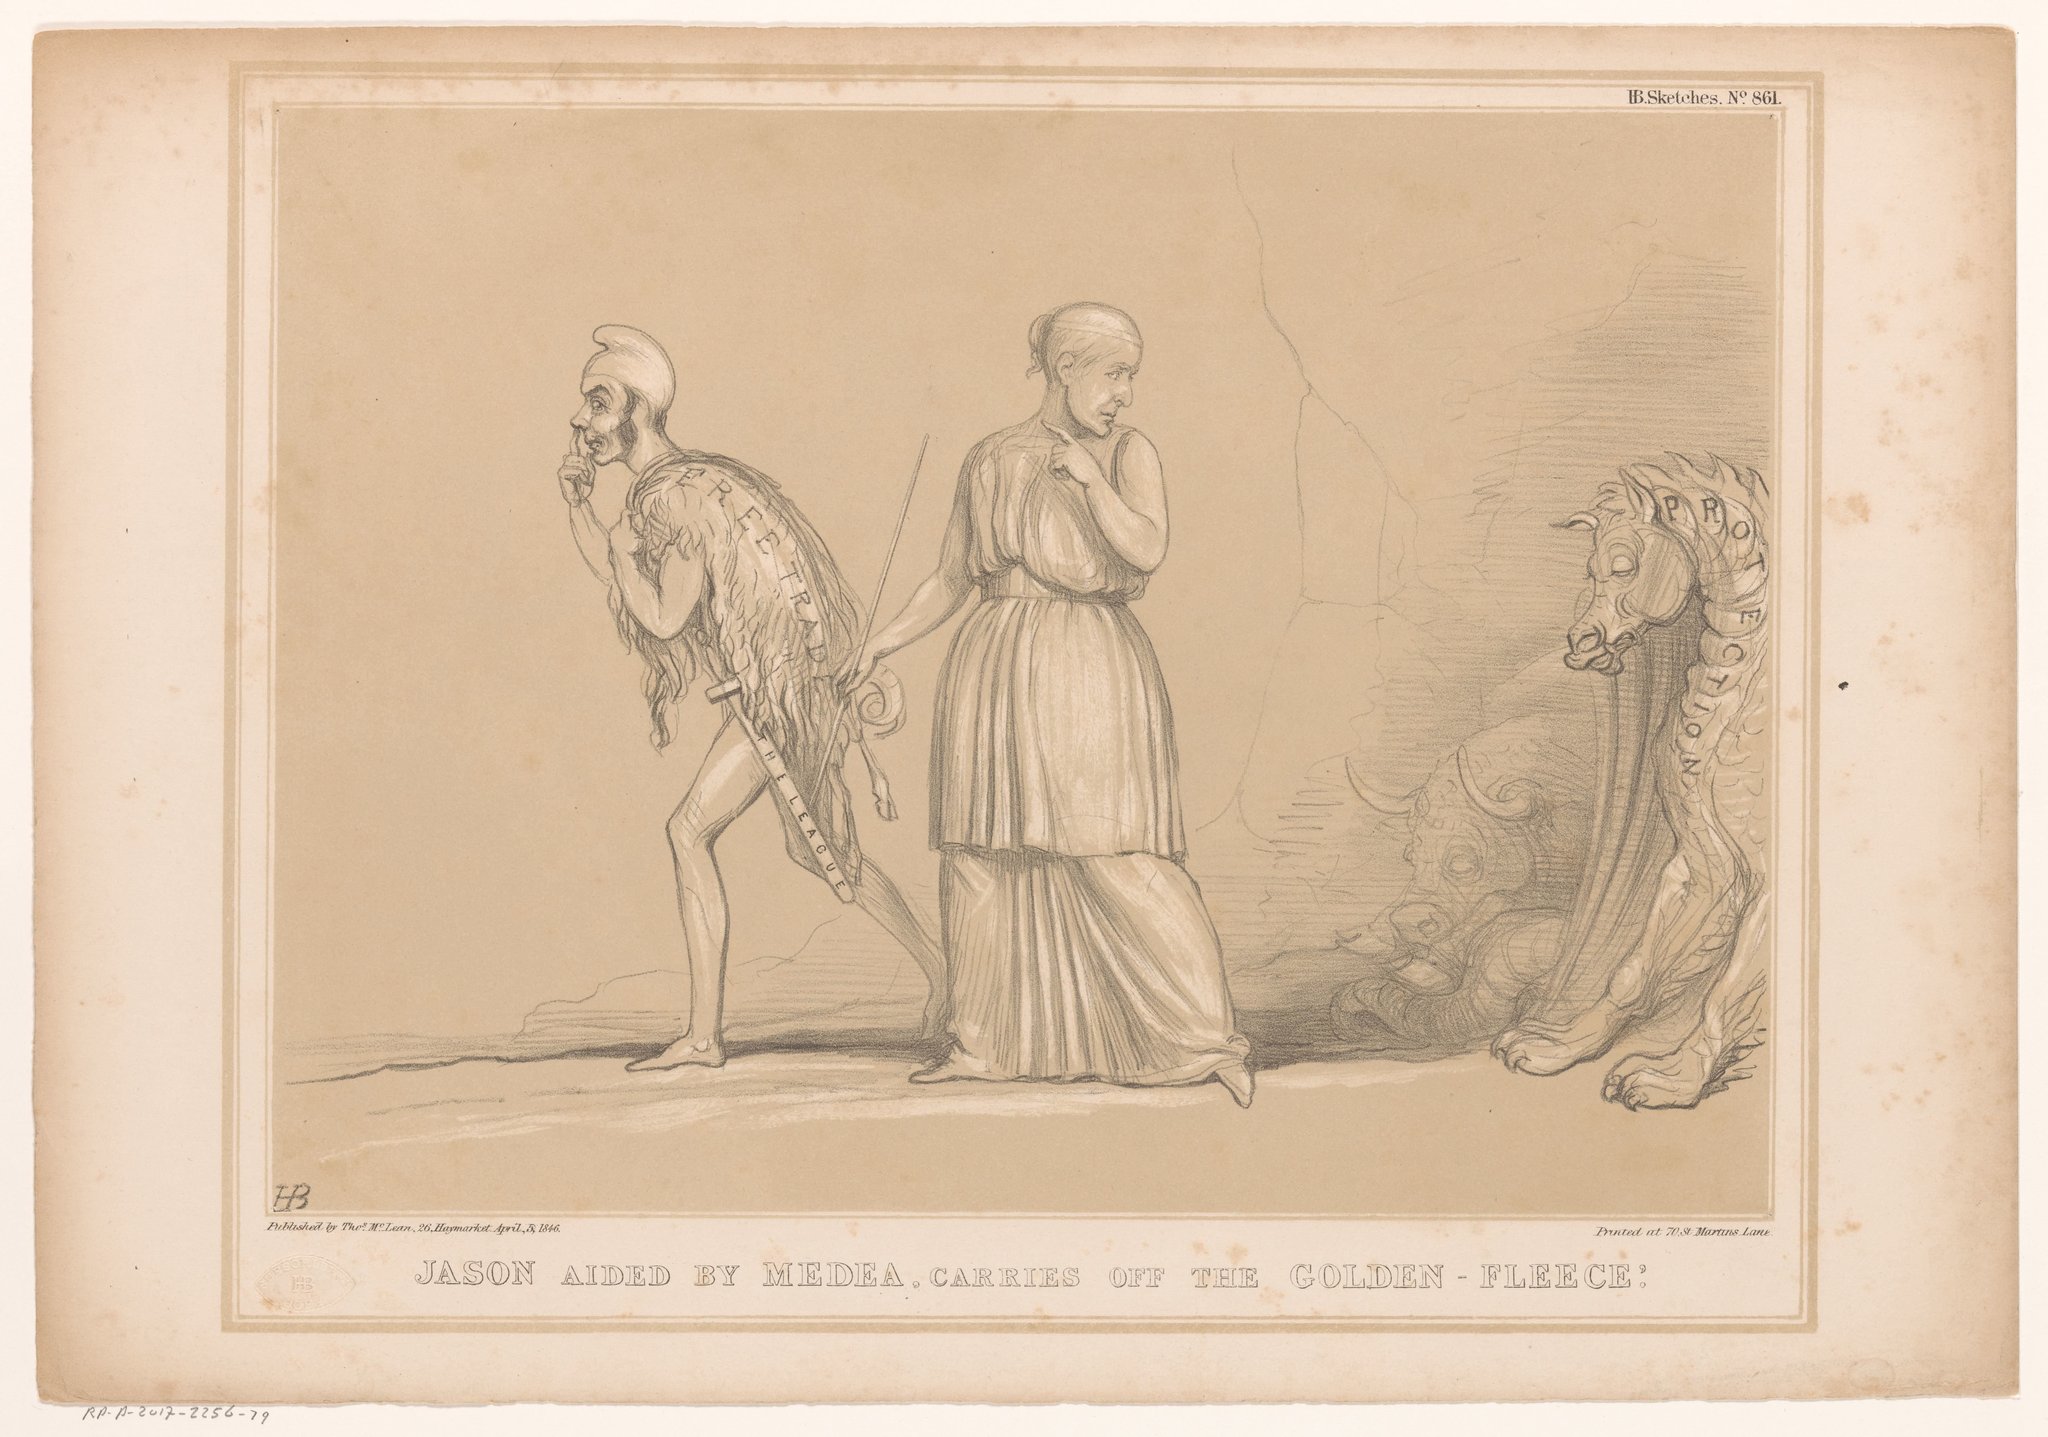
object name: print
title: Jason, aided by Medea, carries off the Golden-Fleece'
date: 1846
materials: paper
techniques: tone lithography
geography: england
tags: london, the golden fleece, hanging on an oak-tree, is seized by jason, political caricatures and satires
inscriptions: stamp: ‘HB Subscribers Copy’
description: Spotprent uit 1846 waarin Richard Cobden als Jason, geholpen door Robert Peel als Medea het Gulden Vlies van de vrijhandel steelt. Uitgegeven als nr. 861 in de serie HB Sketches.